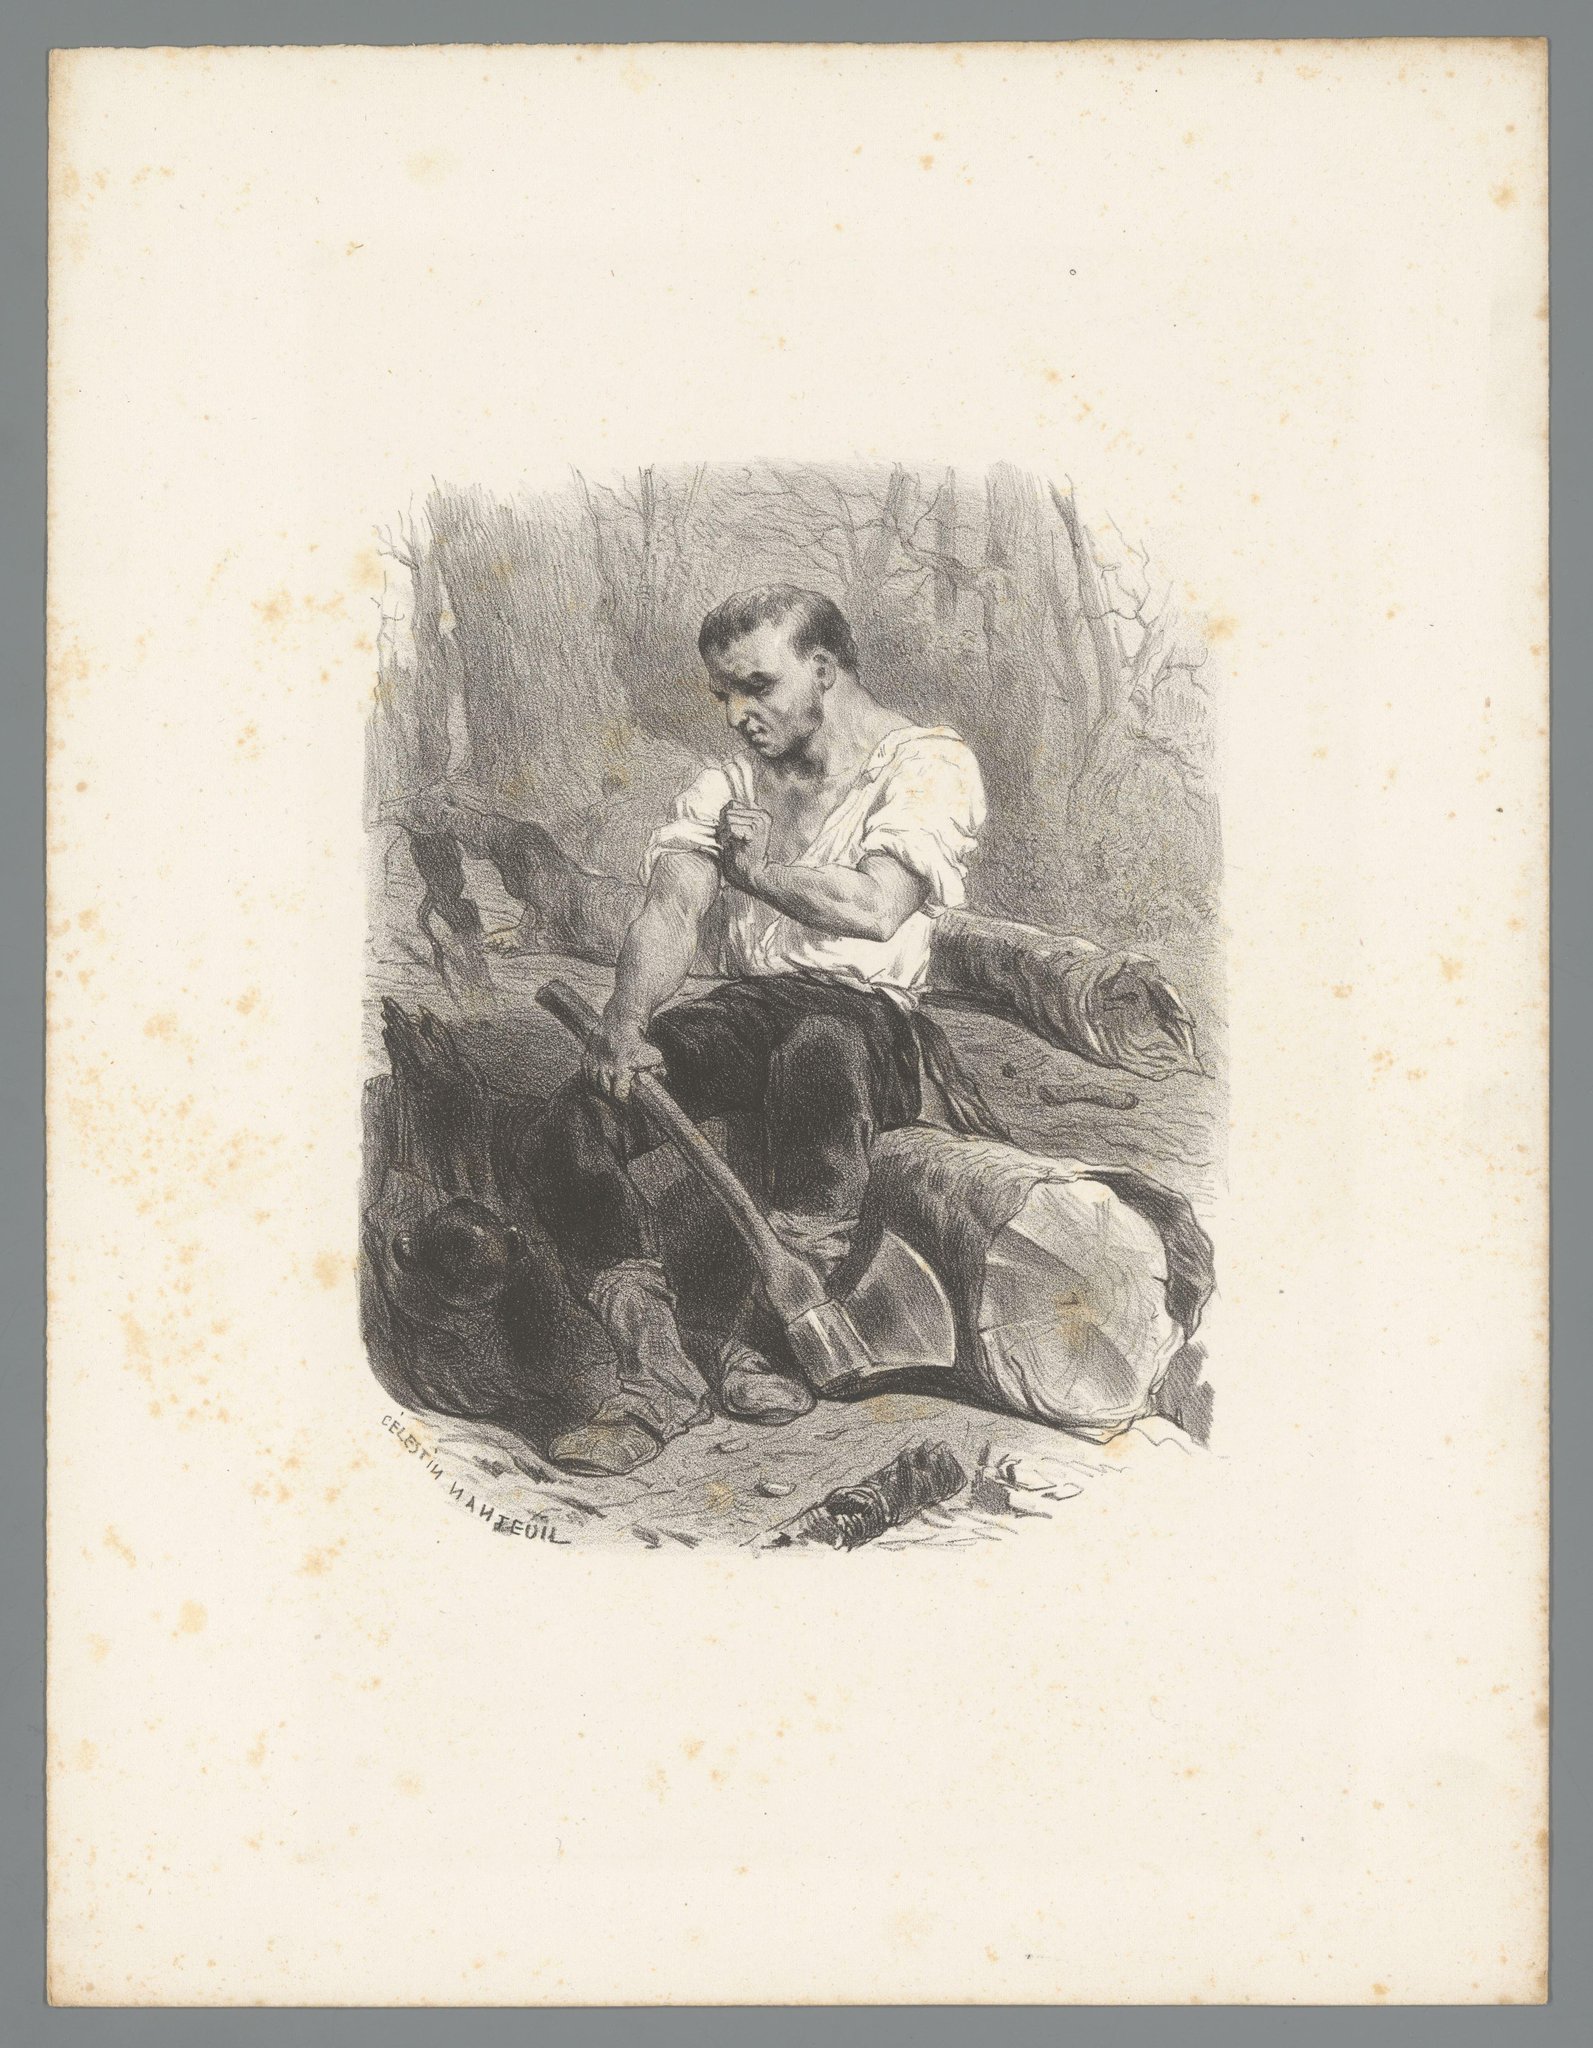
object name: print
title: Houthakker zittend op een boomstam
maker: célestin françois nanteuil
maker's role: print maker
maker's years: 1813-1873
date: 1823-1873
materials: paper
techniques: lithograph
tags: woodcutting, woodcutter ~ forestry, tools, aids, implements ~ crafts and industries: axe, forest, wood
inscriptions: collector's mark: Lugt 964